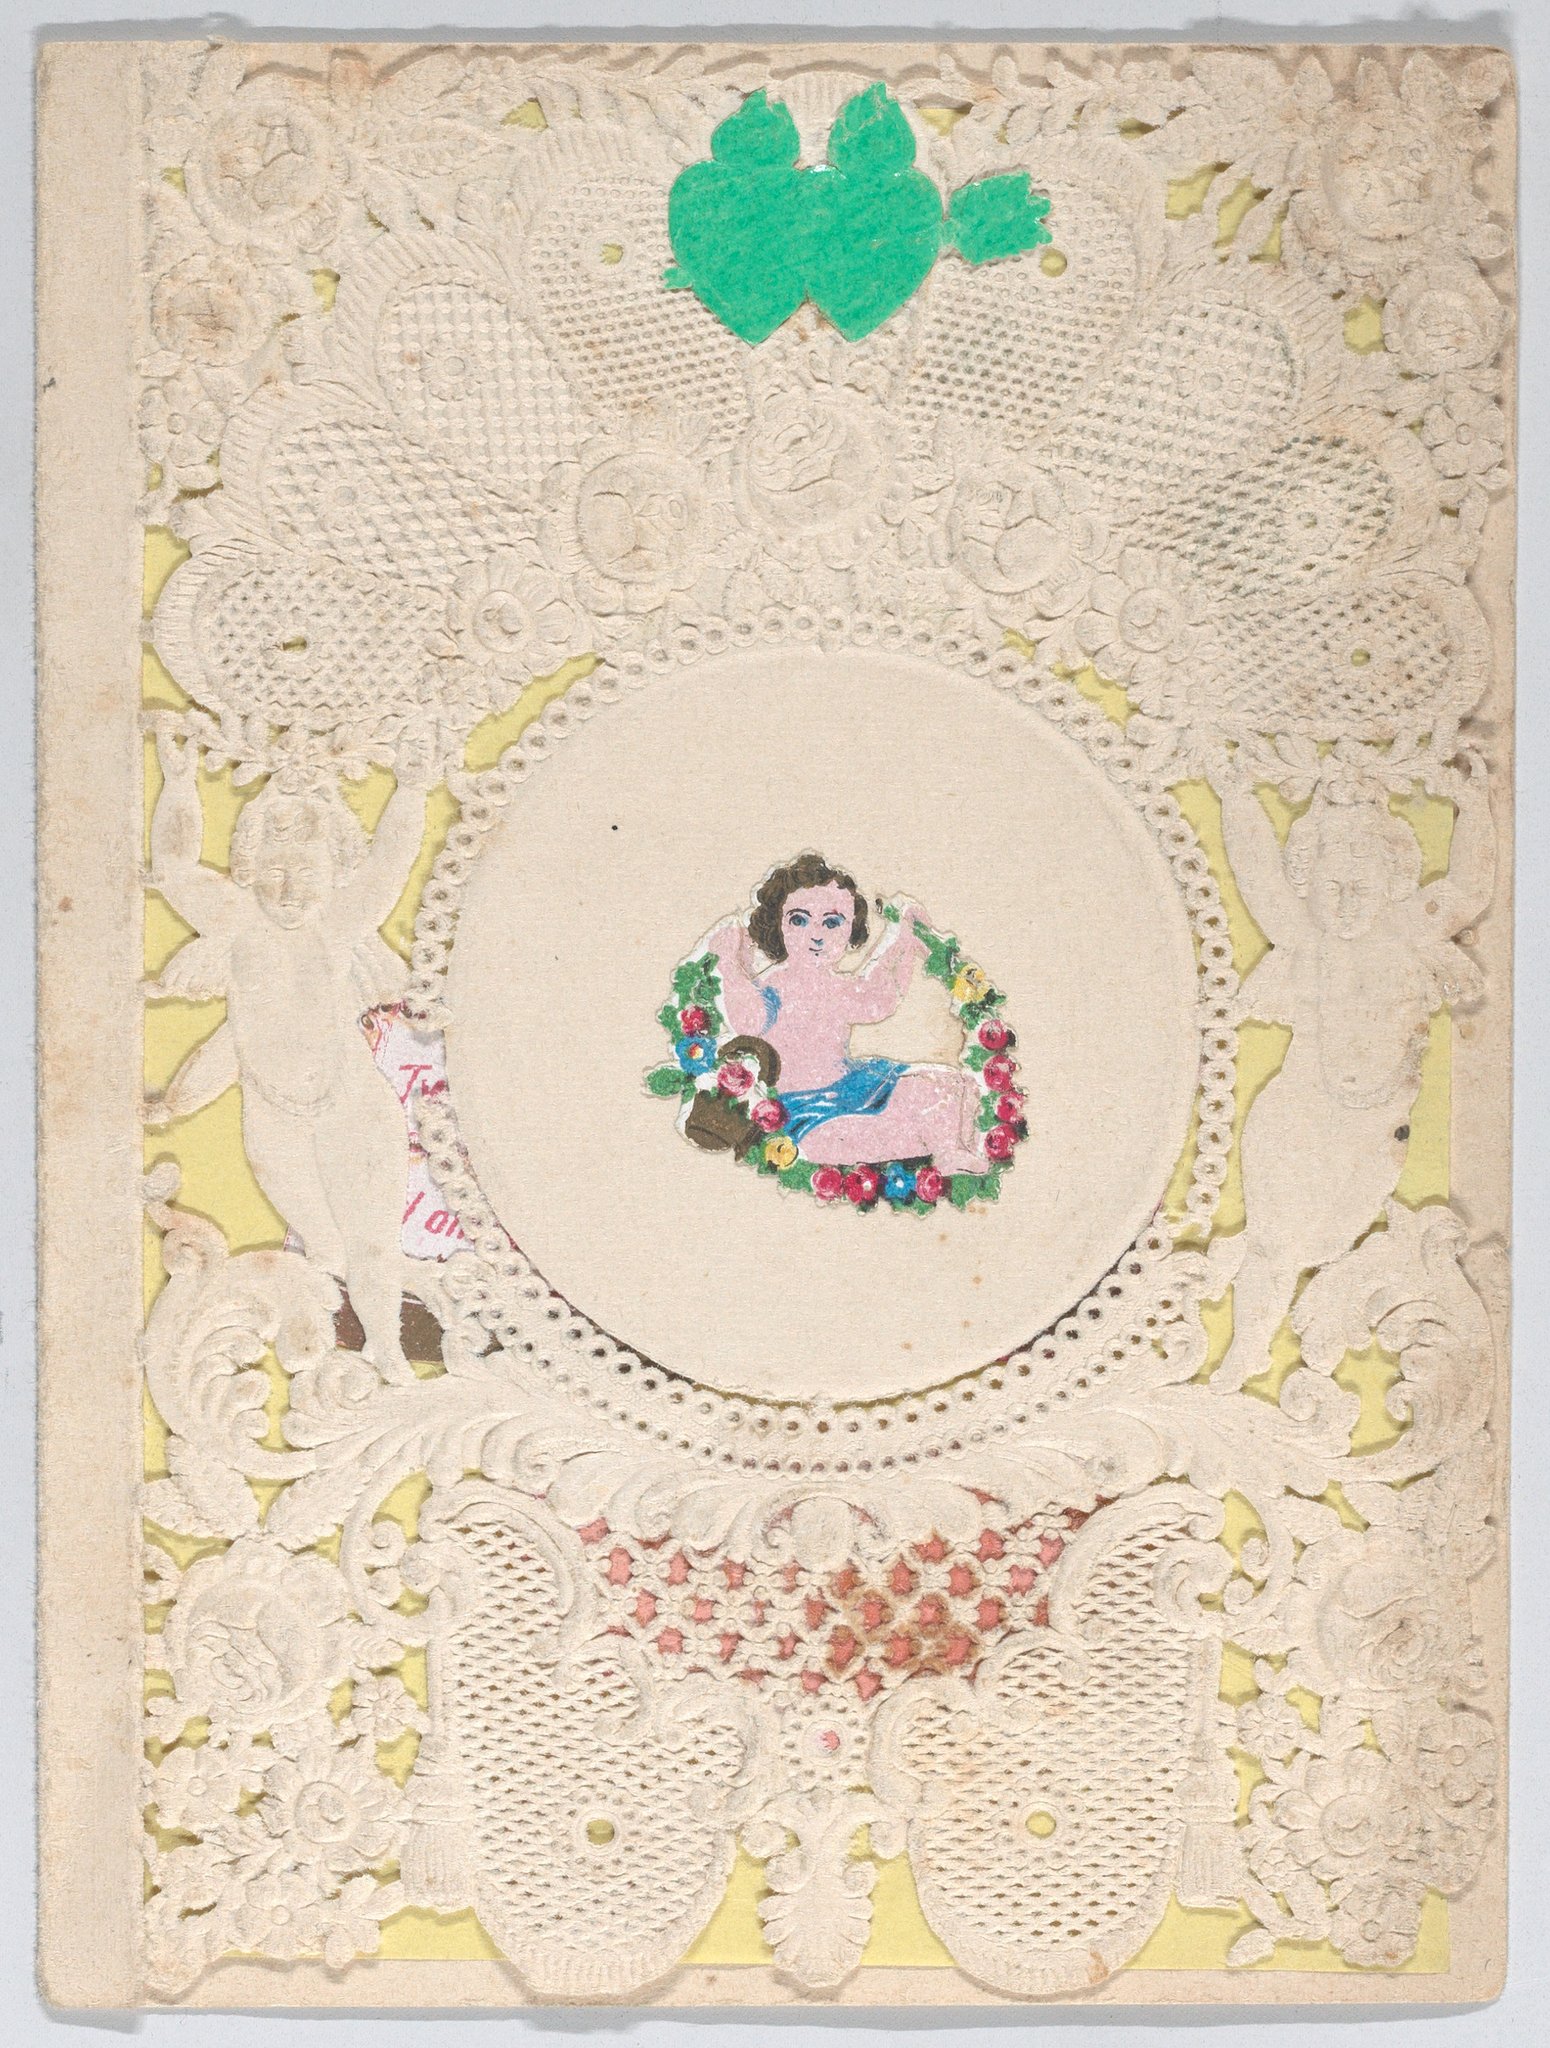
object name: valentine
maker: Anonymous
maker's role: artist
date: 1850-1870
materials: ink, lace, paper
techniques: embossing, open work